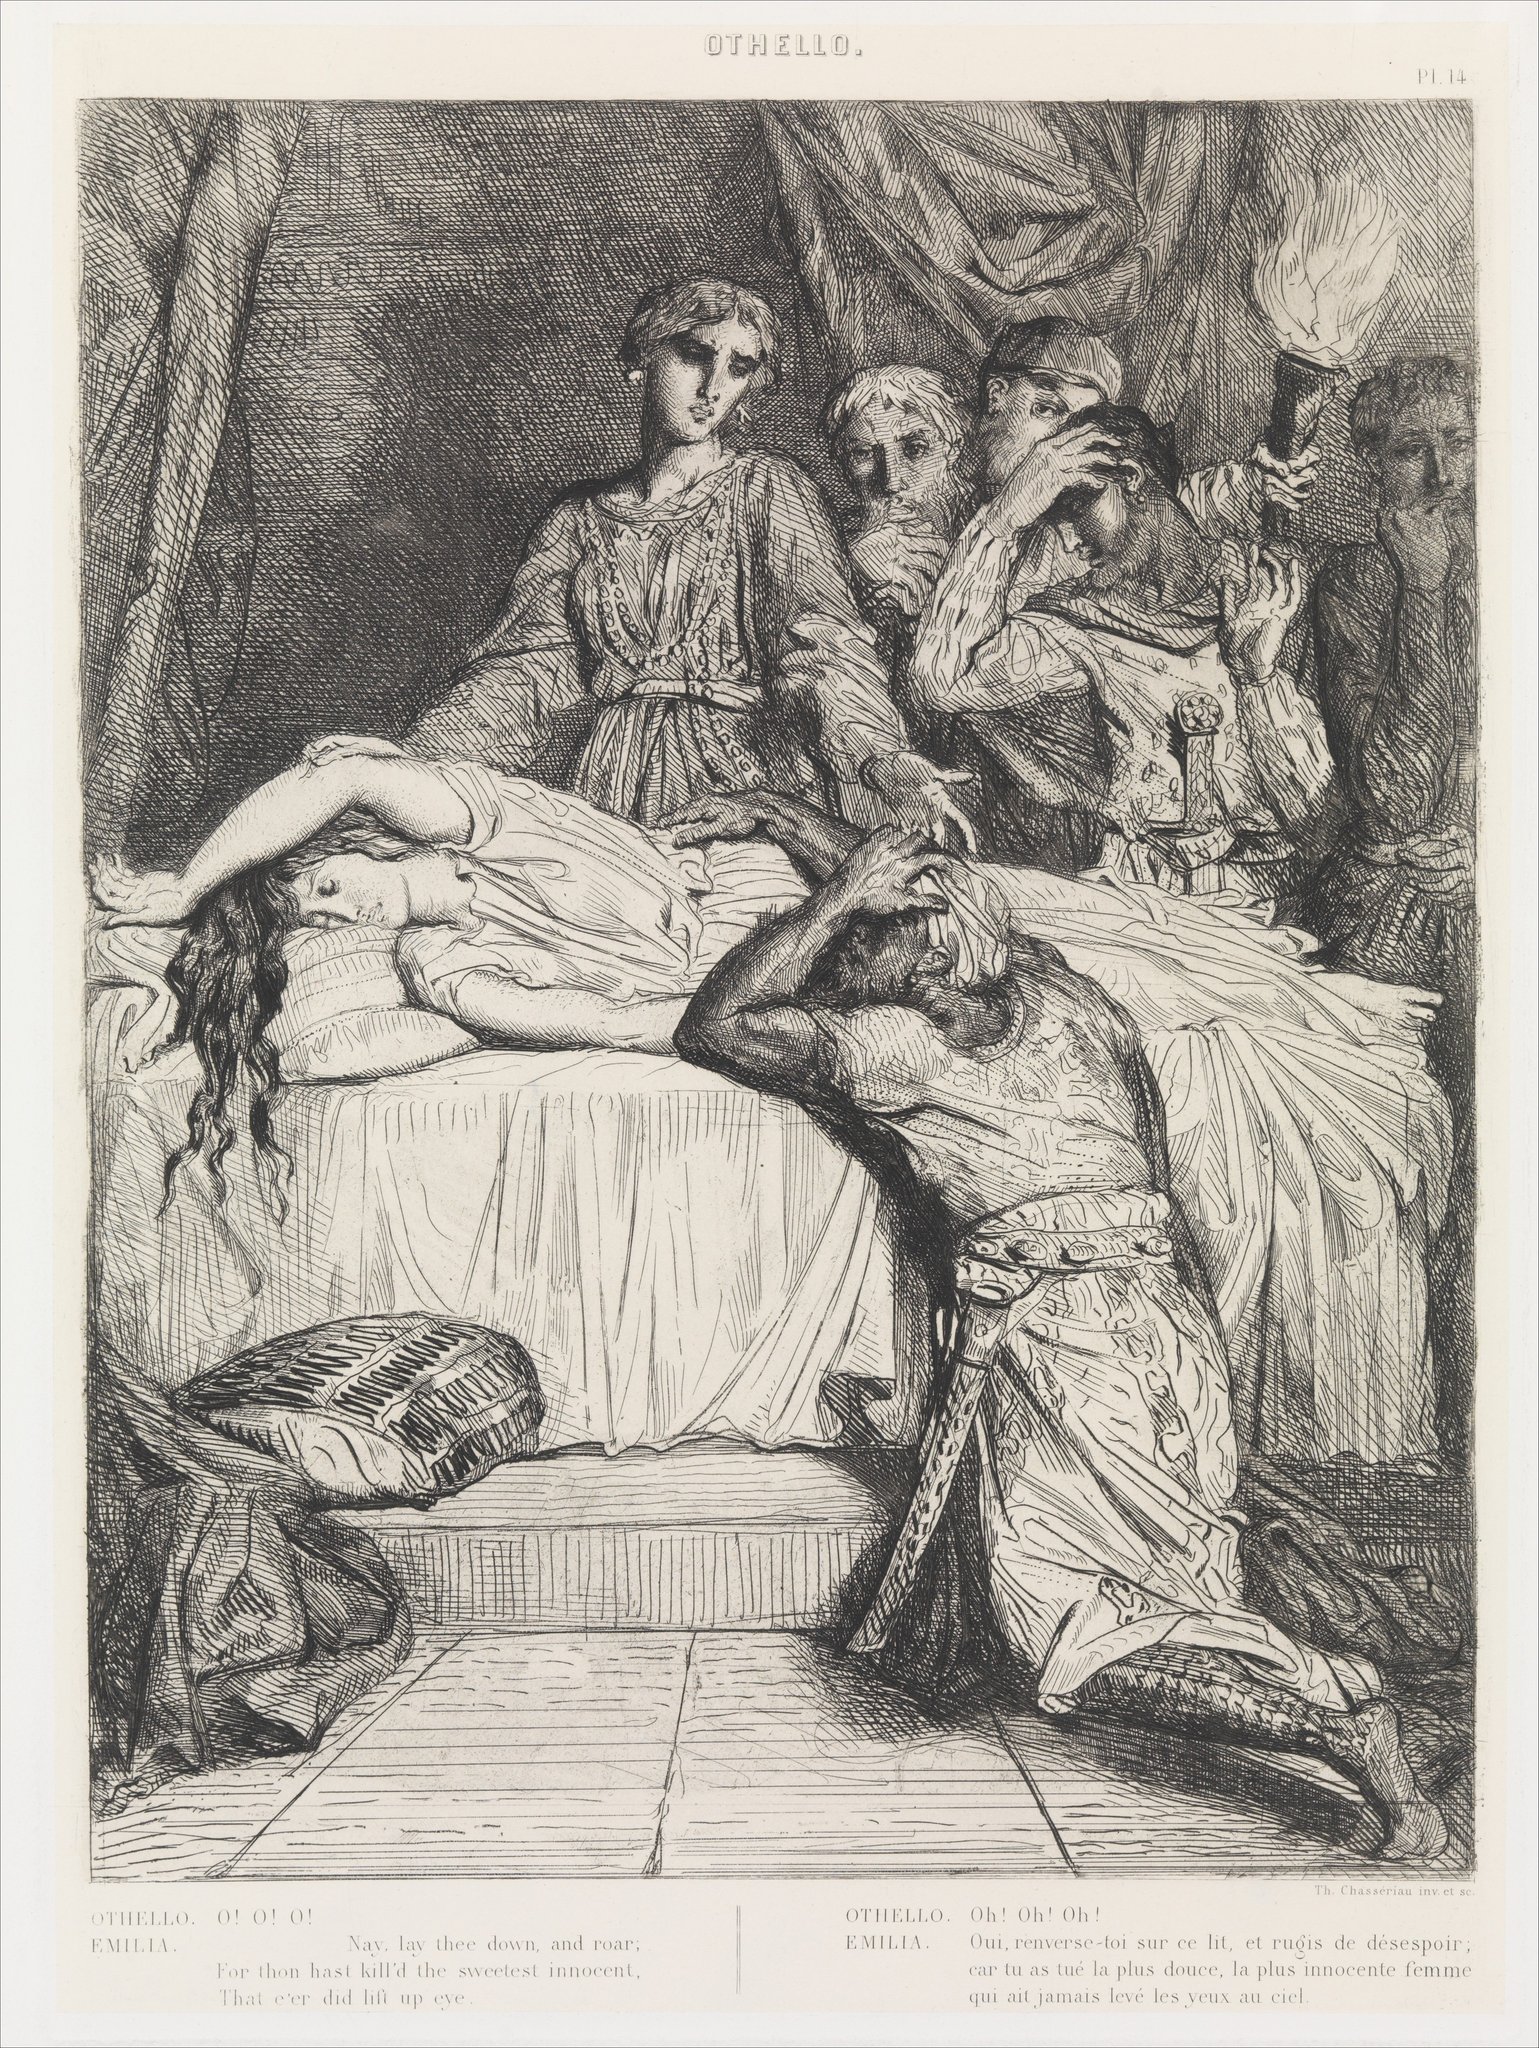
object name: print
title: "Oh! Oh! Oh!": plate 14 from Othello (Act 5, Scene 2)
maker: théodore chassériau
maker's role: artist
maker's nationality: french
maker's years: 1819-1856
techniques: printmaking, engraving, etching, roulette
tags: shakespeare,sadness,men,women,death